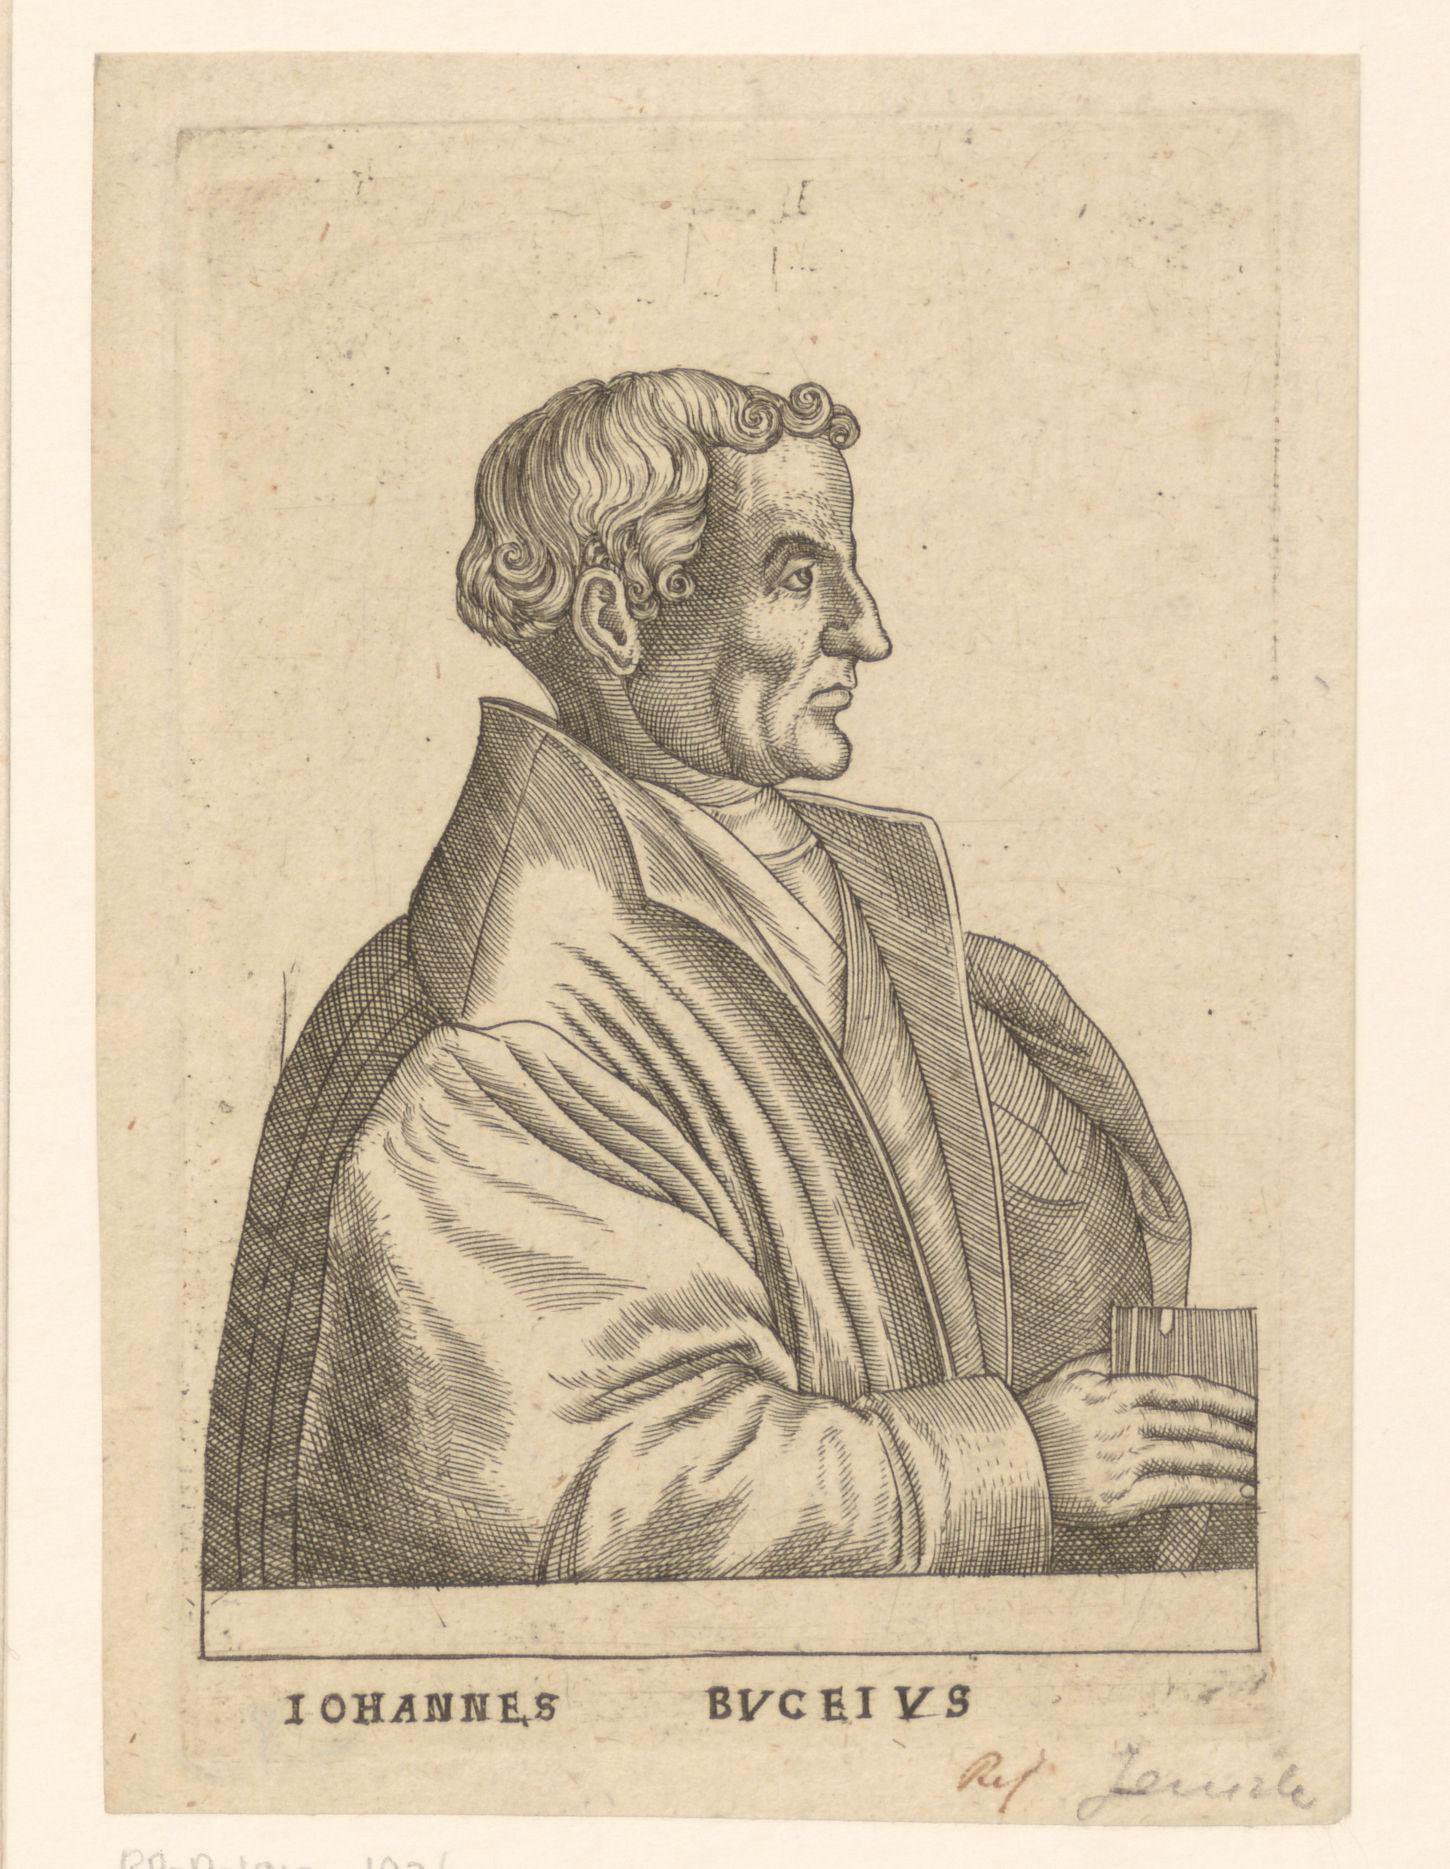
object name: print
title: Portret van Johannes Bucheius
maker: Anonymous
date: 1563-1642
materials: paper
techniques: engraving, etching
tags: theologian, historical persons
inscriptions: collector's mark: Lugt 2228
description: Deze prent (een impressie) hoort bij een serie portretten van sturende personen tijdens de reformatie.